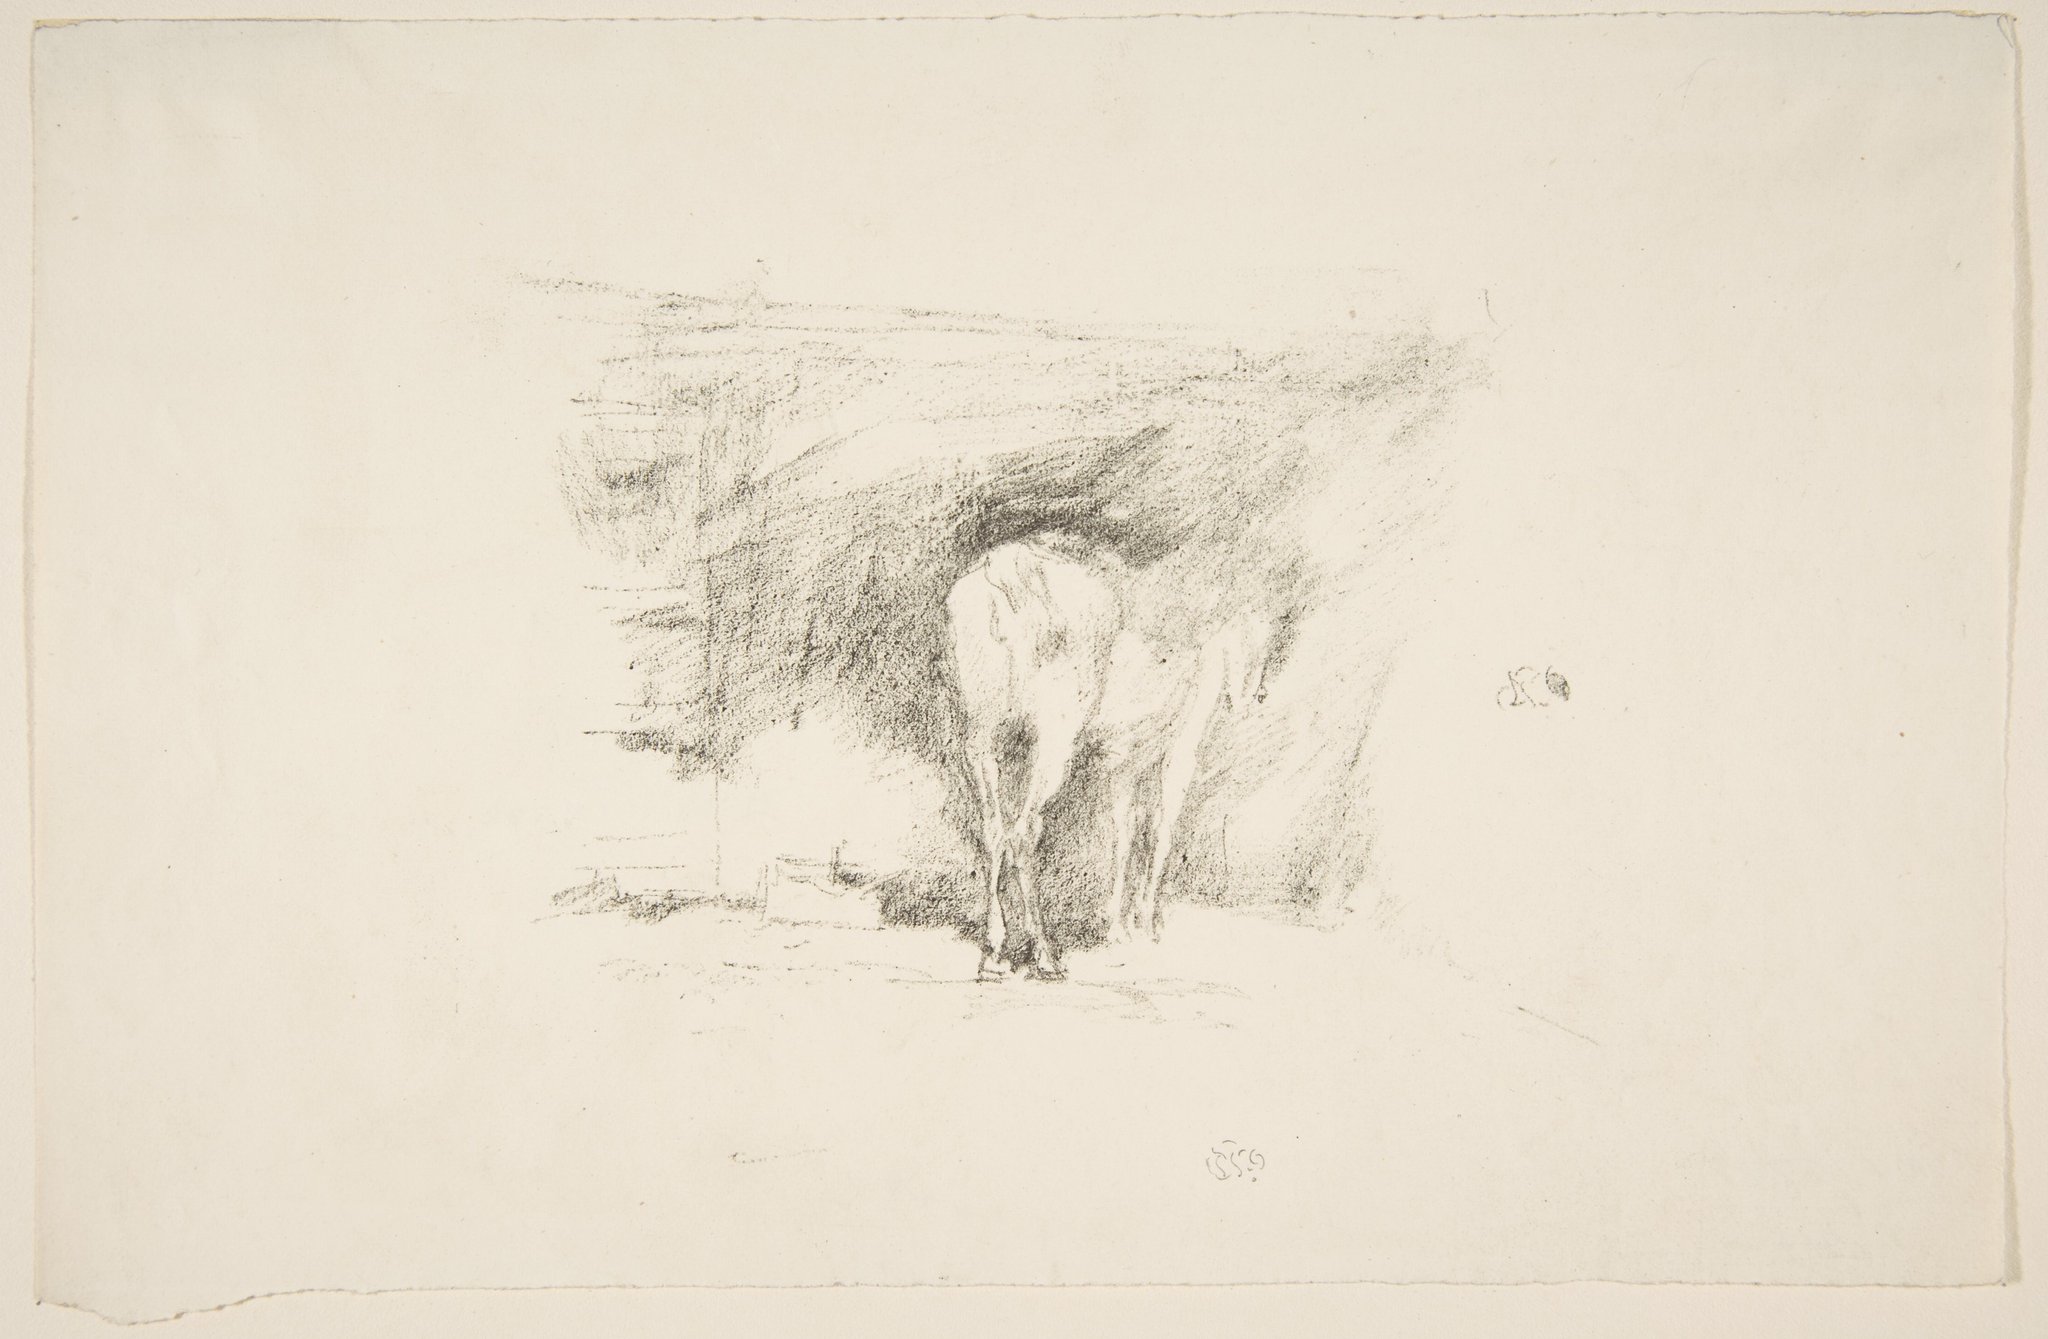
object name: print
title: Study of a Horse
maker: james mcneill whistler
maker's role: artist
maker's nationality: american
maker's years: 1834-1903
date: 1895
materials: ink, paper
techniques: printing, lithography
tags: horses